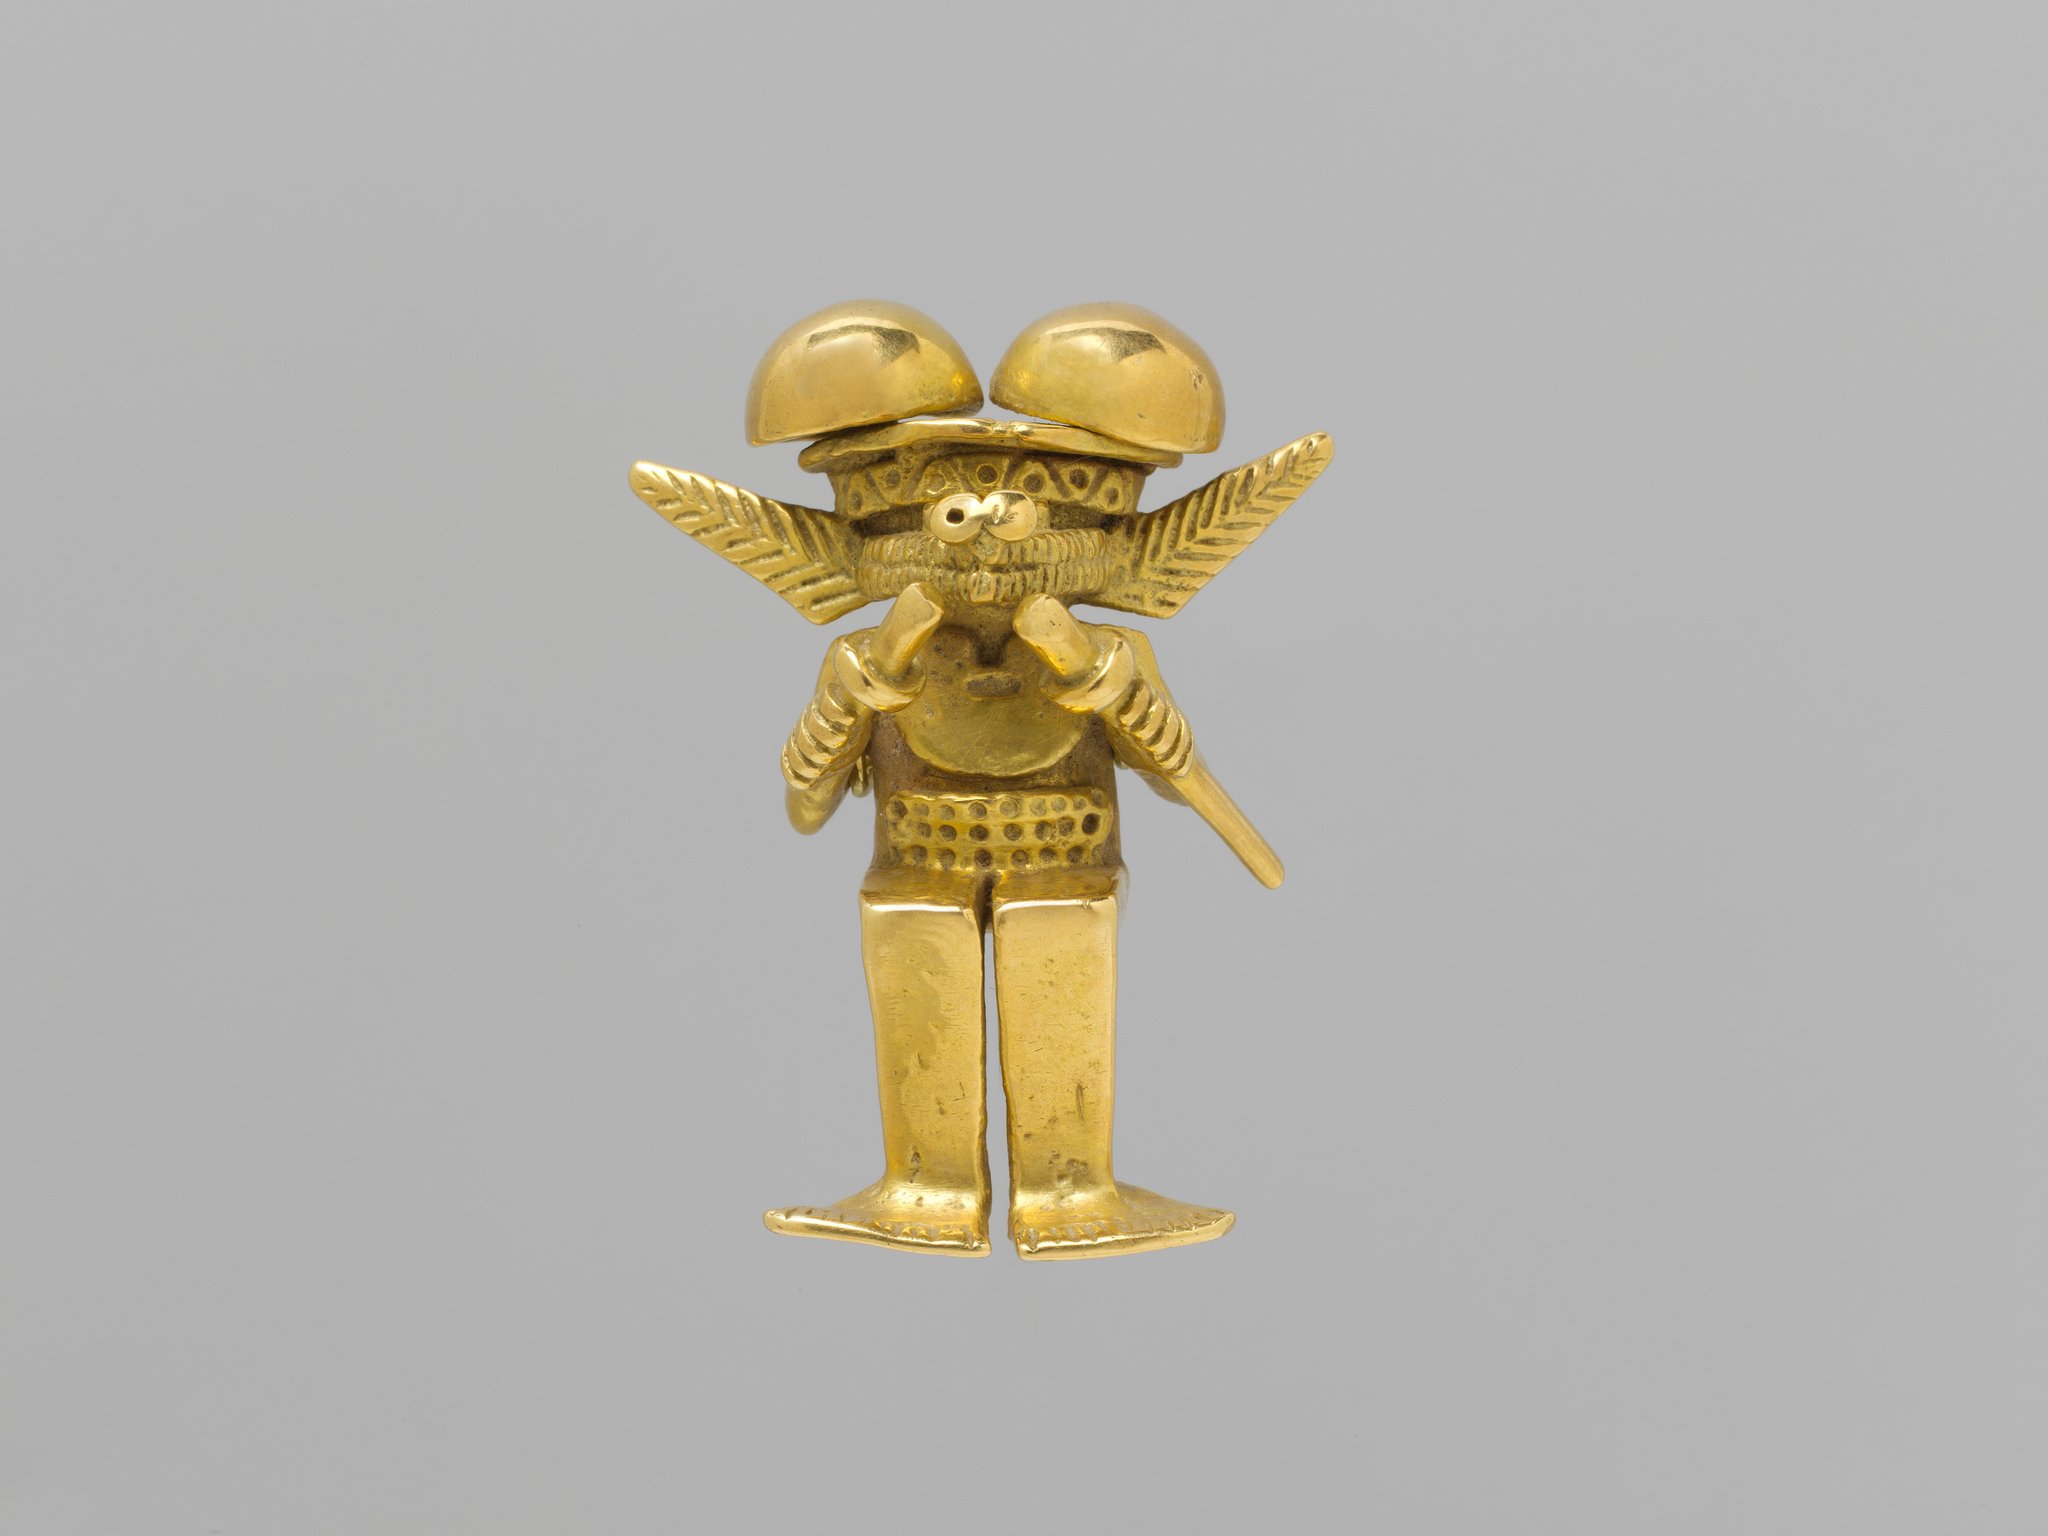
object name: pendant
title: Masked Figure Pendant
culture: calima or yotoco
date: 1-700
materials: gold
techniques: casting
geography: colombia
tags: human figures,masks